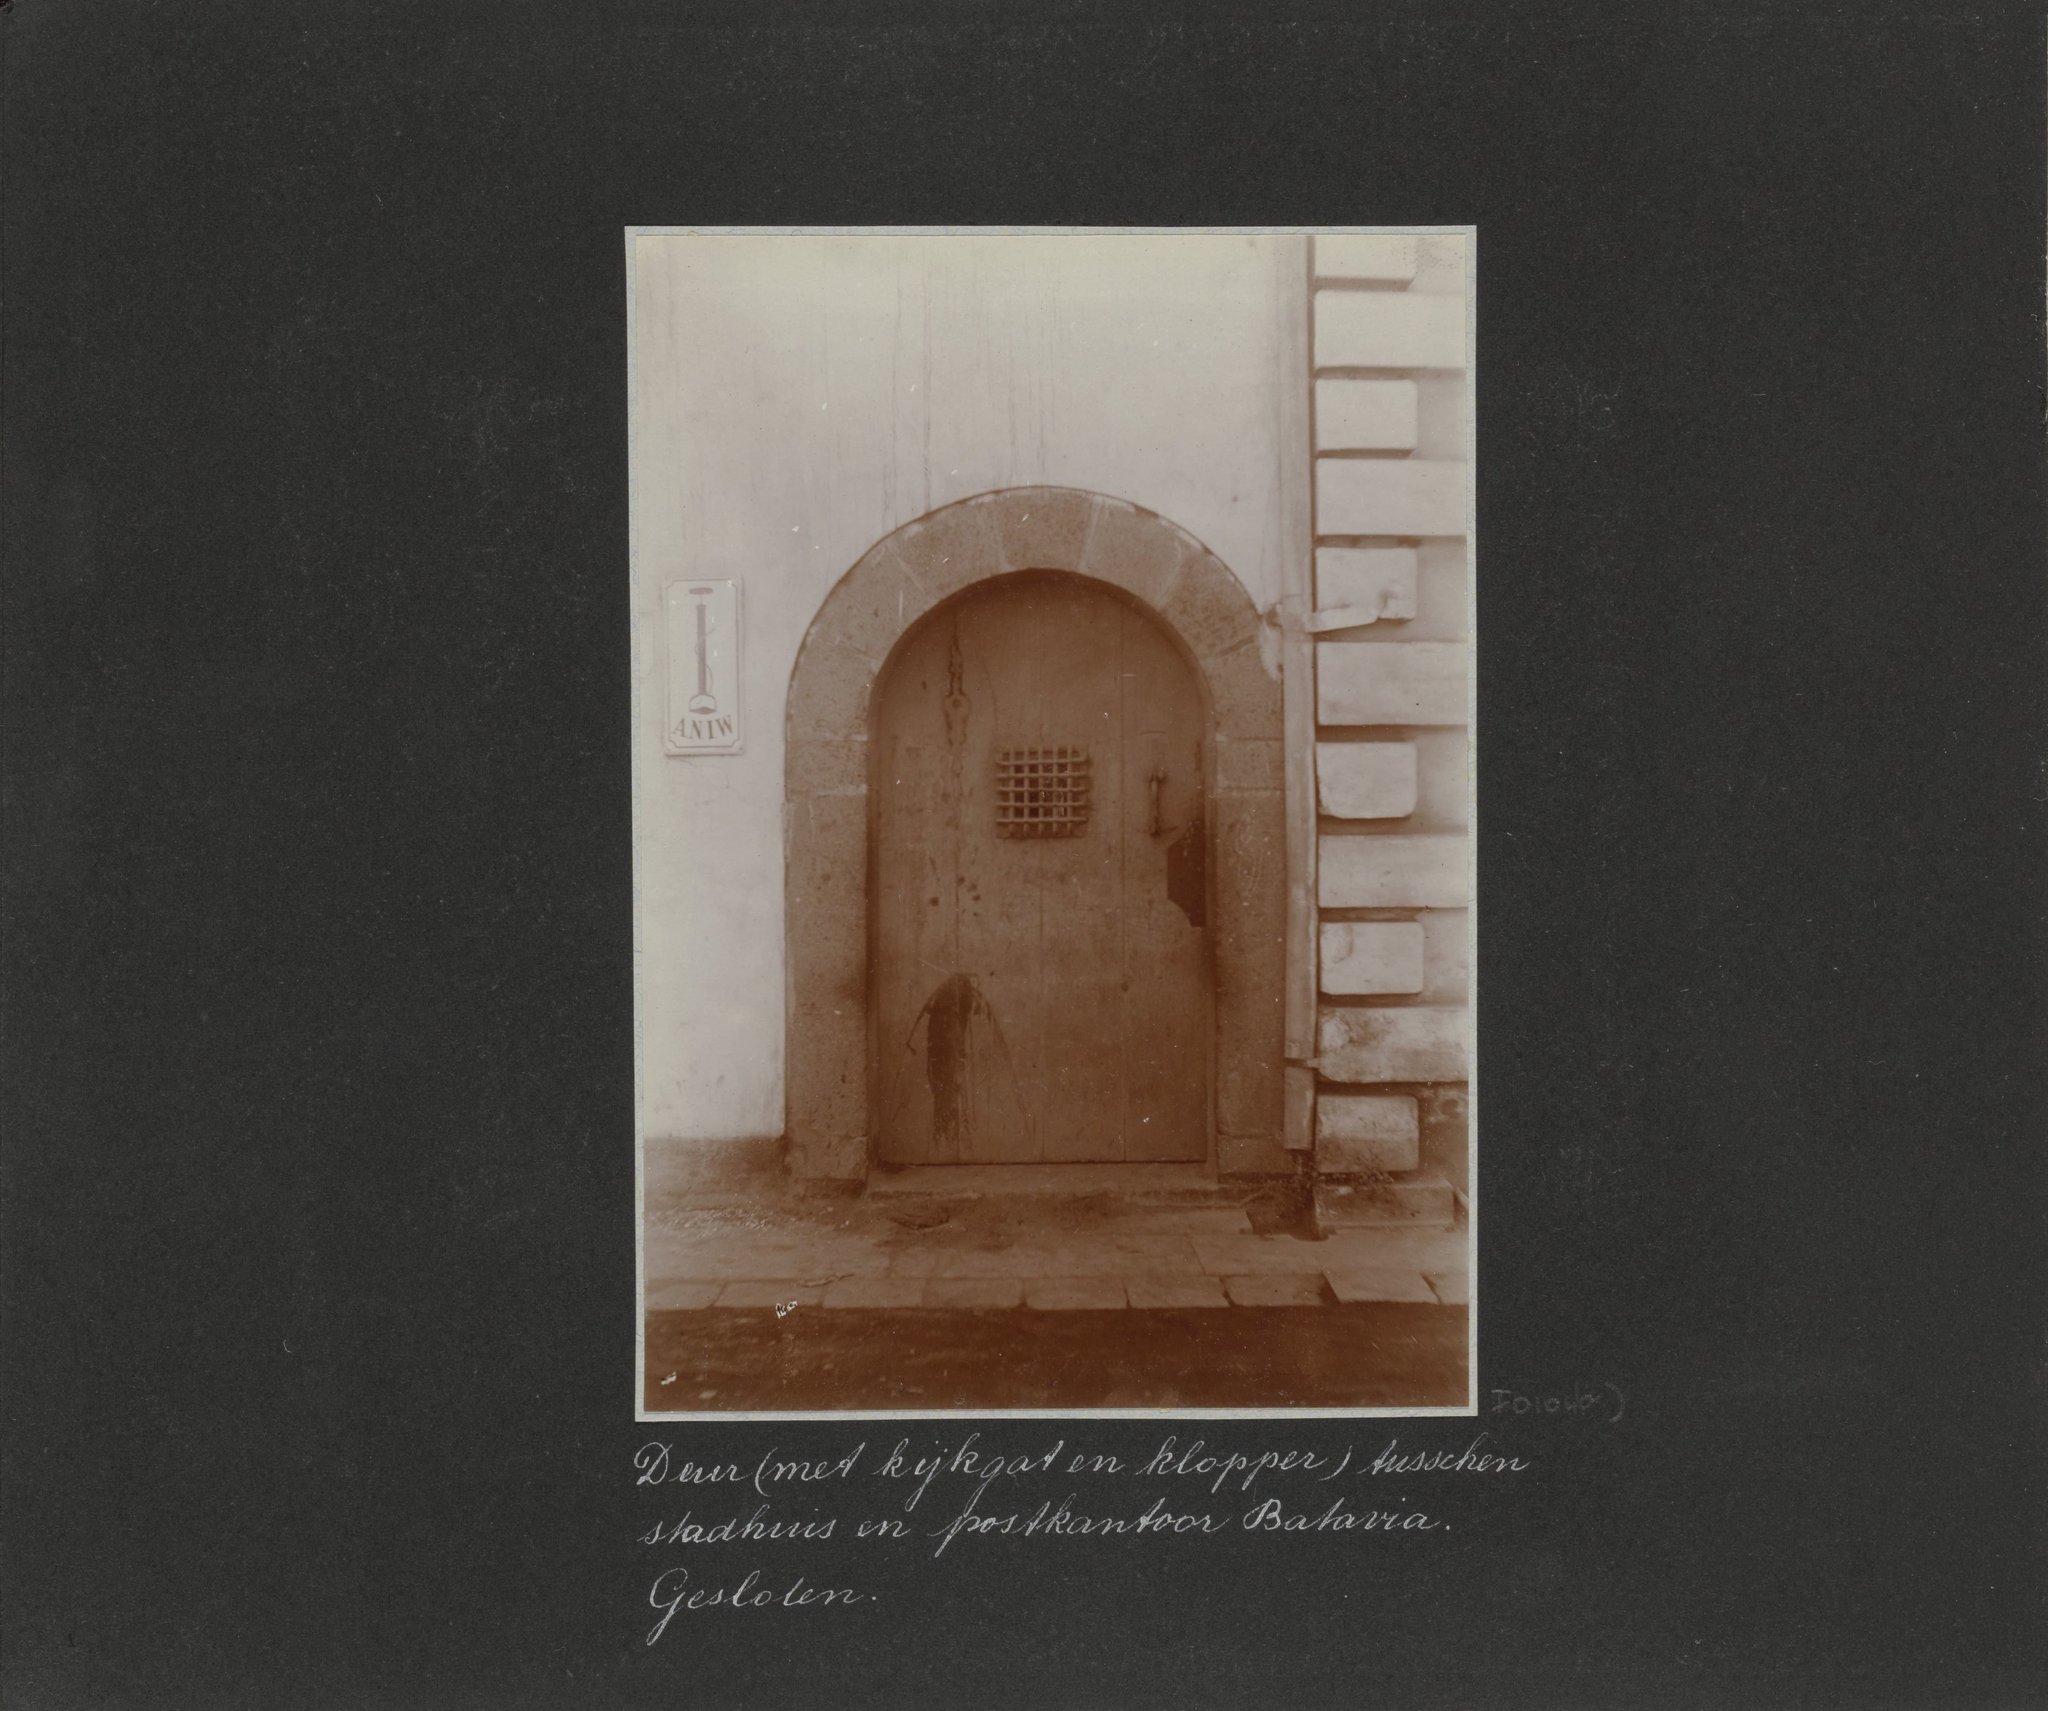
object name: album leaf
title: Deur (met kijkgat en klopper) tusschen stadhuis en postkantoor Batavia. Gesloten.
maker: Anonymous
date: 1920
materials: paper, photographic support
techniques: gelatin silver print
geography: batavia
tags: gate, entrance, dutch east indies, the, batavia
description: Onderdeel van Reisalbum met foto's van Batavia.